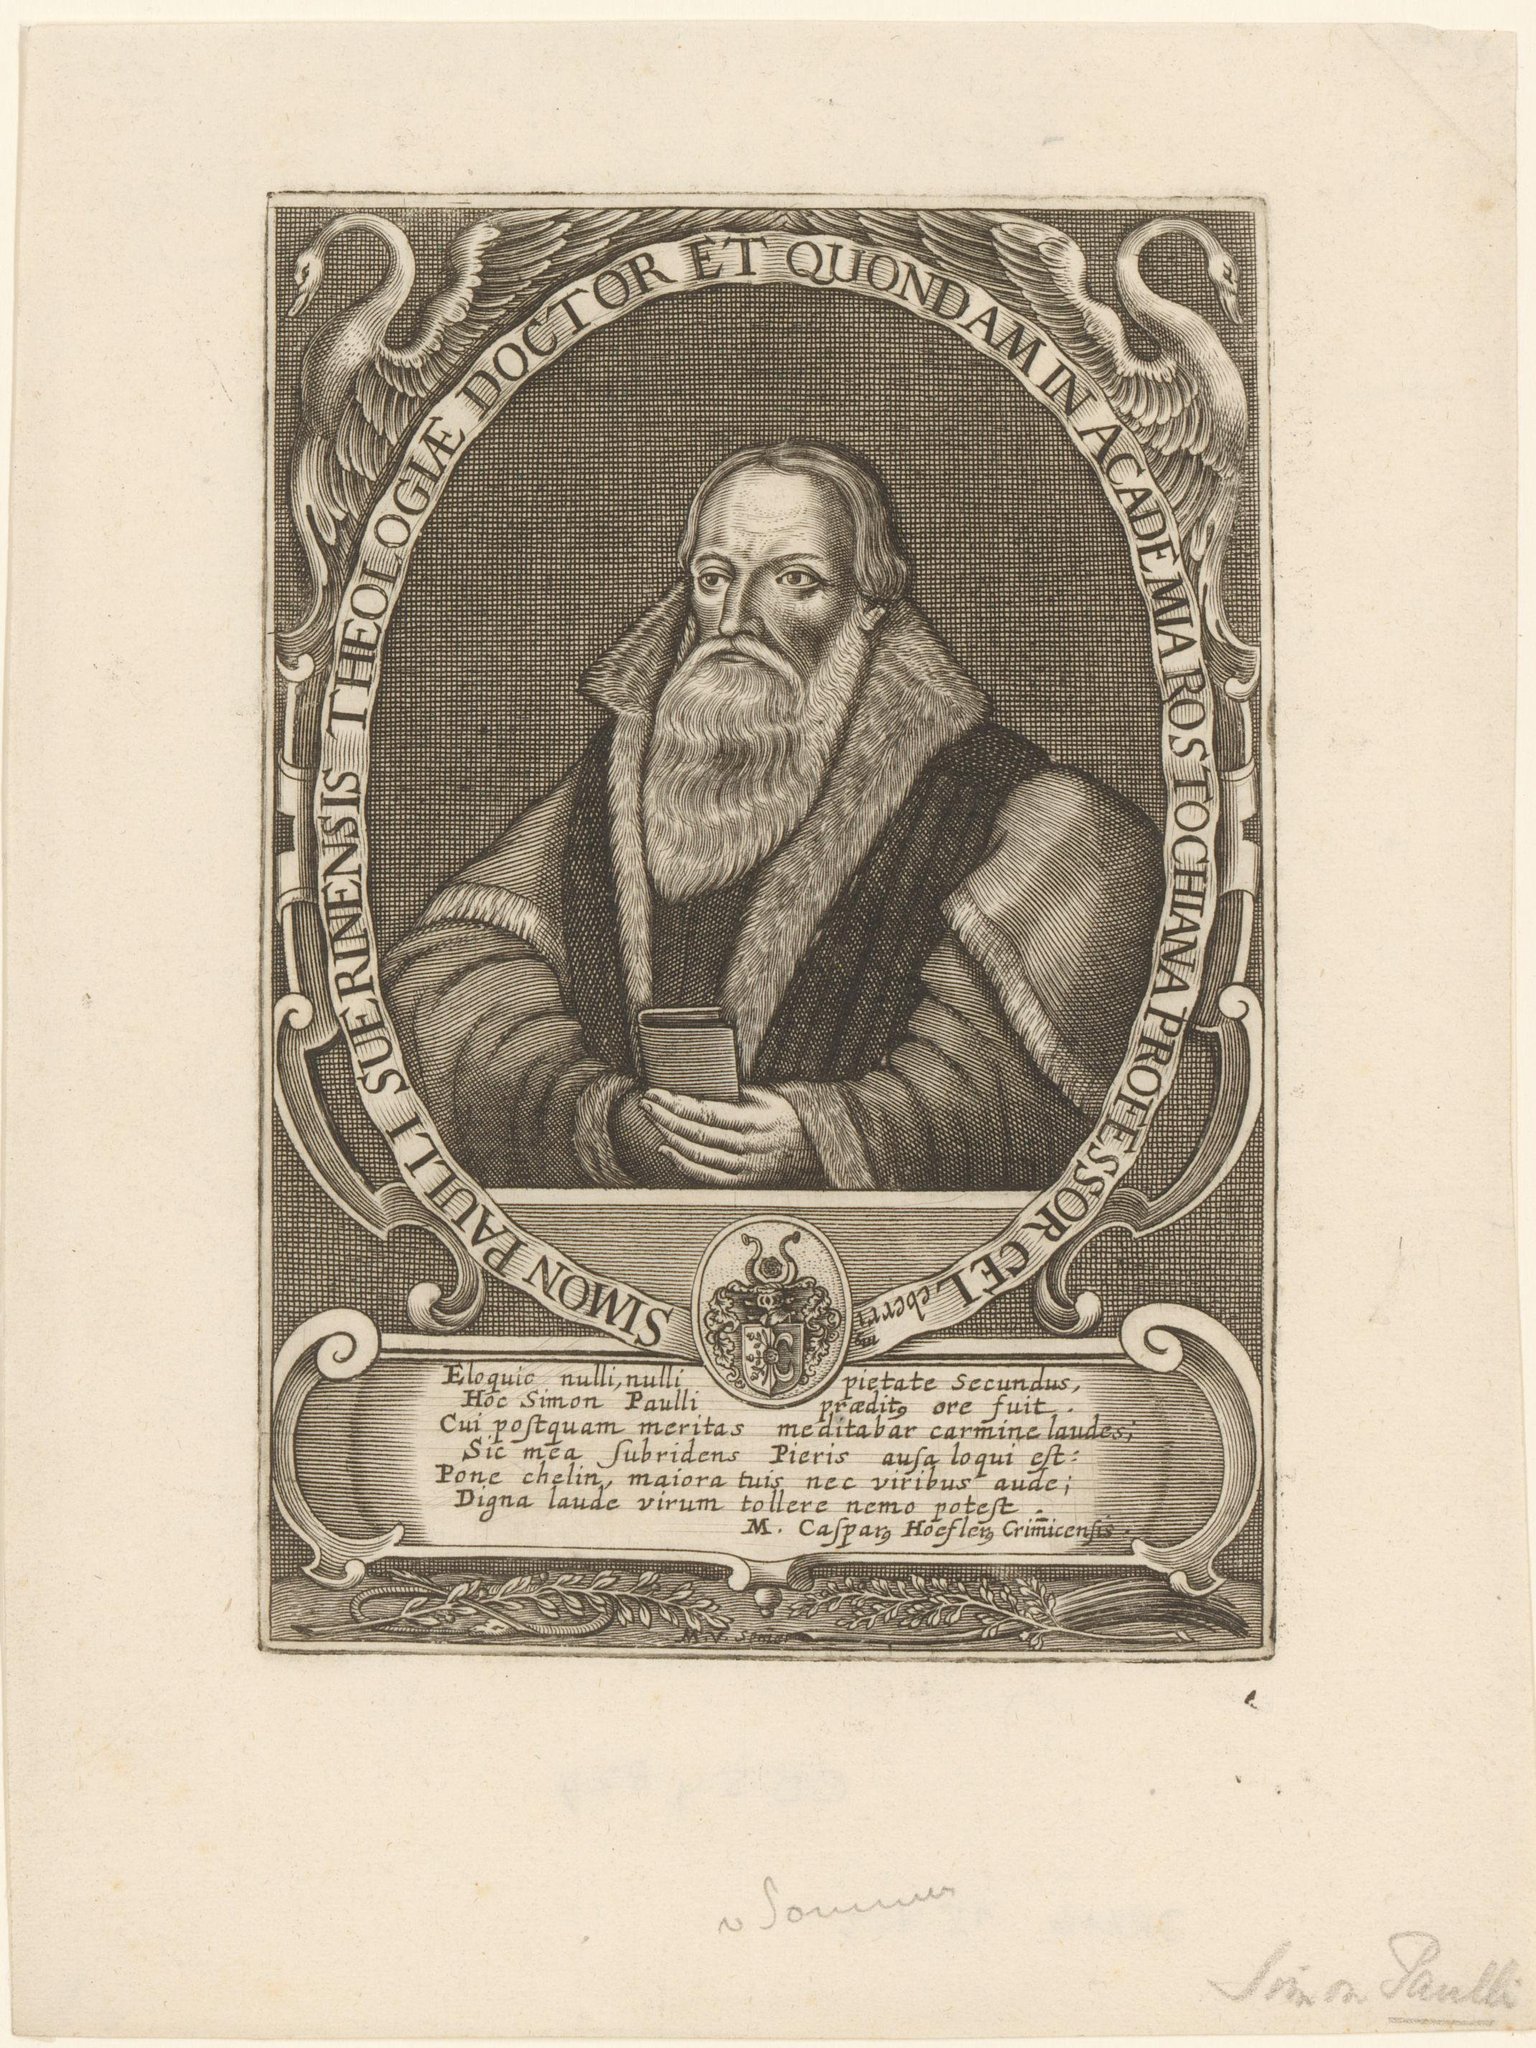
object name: print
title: Portret van Simon Paulli I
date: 1643-1672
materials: paper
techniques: engraving, etching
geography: germany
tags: historical persons, book, armorial bearing, heraldry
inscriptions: collector's mark: Lugt 2228